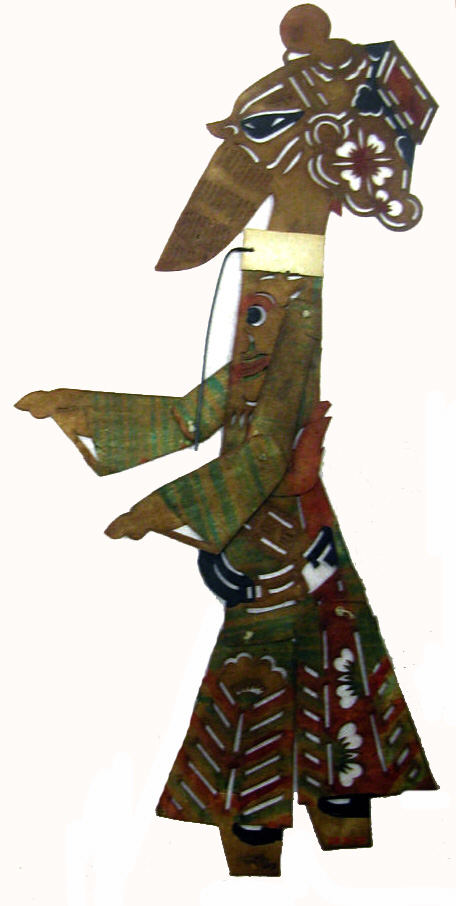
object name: shadow player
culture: chinese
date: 1801-1900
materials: cord, skin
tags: human figures